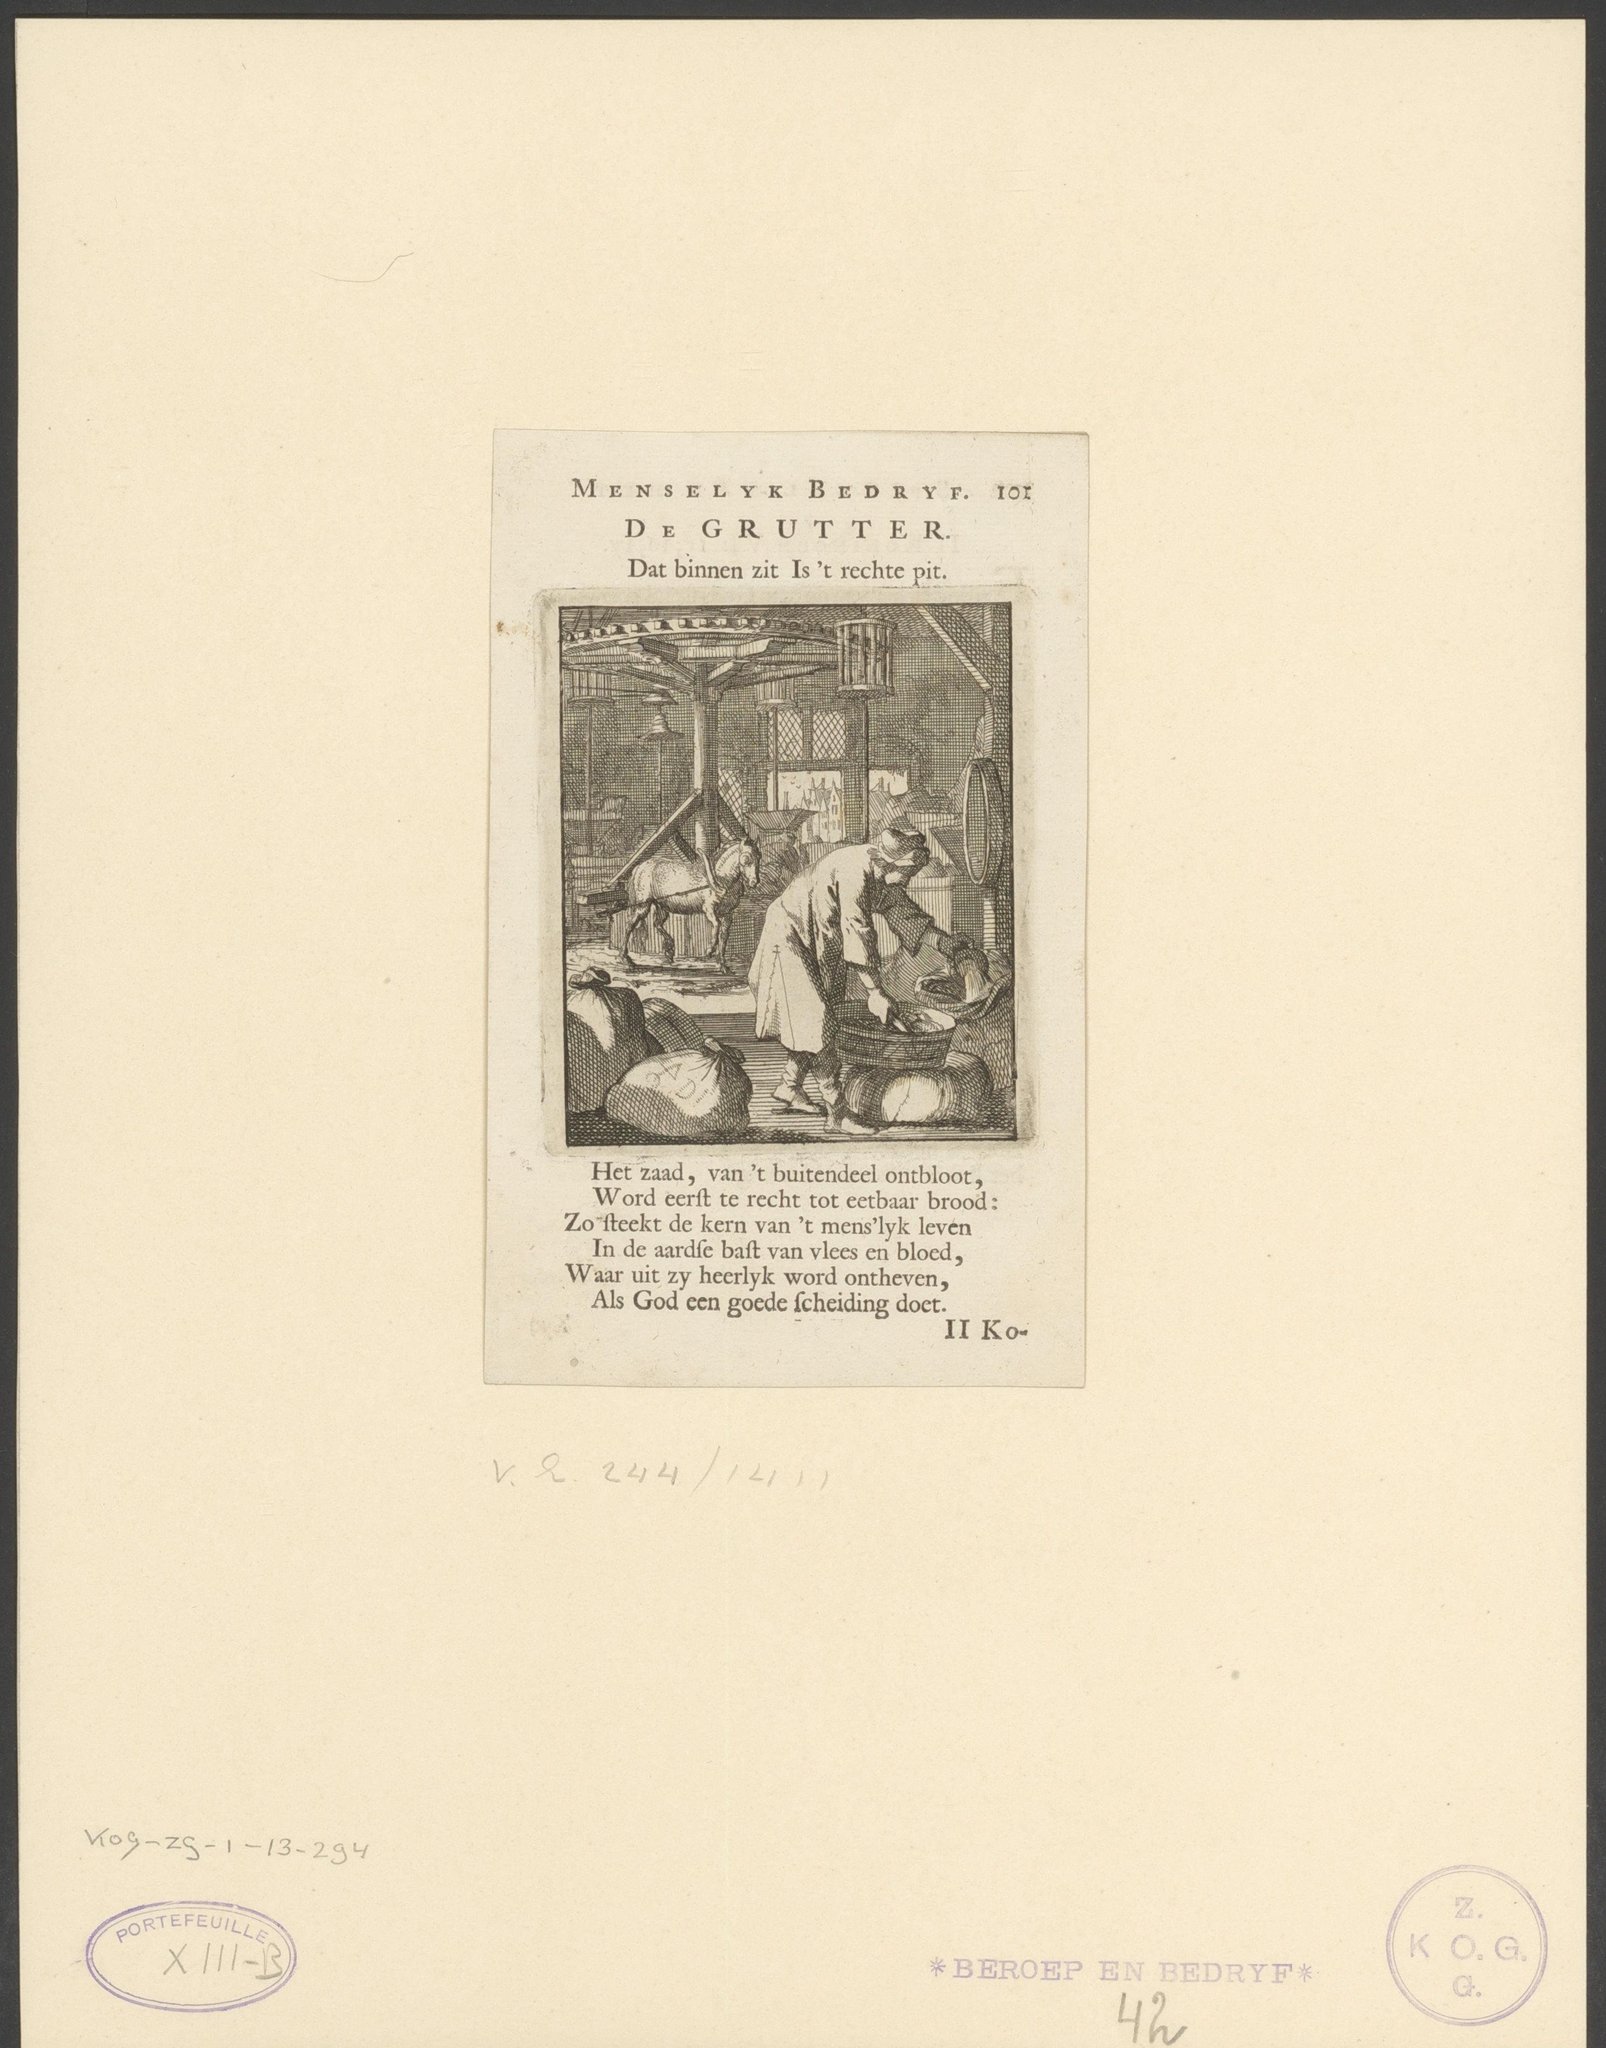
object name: print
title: Gruttenmaker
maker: cornelis van der sys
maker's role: publisher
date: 1718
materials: paper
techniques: etching, letterpress printing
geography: amsterdam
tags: handicrafts, craftsman at work, handicrafts ~ other plant material, cereal, grain, corn (grass with grains, grown for food, e.g.: wheat, rice, rye, oats, maize, buckwheat, millet)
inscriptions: stamp, collector's mark: Lugt 1641, stamp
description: Prent oorspronkelijk verschenen in de 100-delige serie beroepsprenten van Jan en Caspar Luyken, getiteld: Het menselyk bedryf. S.l.s.n., 1694 (eerste druk). Daarna is de titel en het vers afgesneden. De prenten in diverse publicaties verschenen en gekopieerd. Huidige staat uit: Luyken, Jan en Caspar. Spiegel van het menselyk bedryf (...). Amsterdam: Cornelis van der Sys, 1718. Prent waarschijnlijk ook gebruikt in eerdere (1704) en latere (1730, 1749, 1767) publicaties.